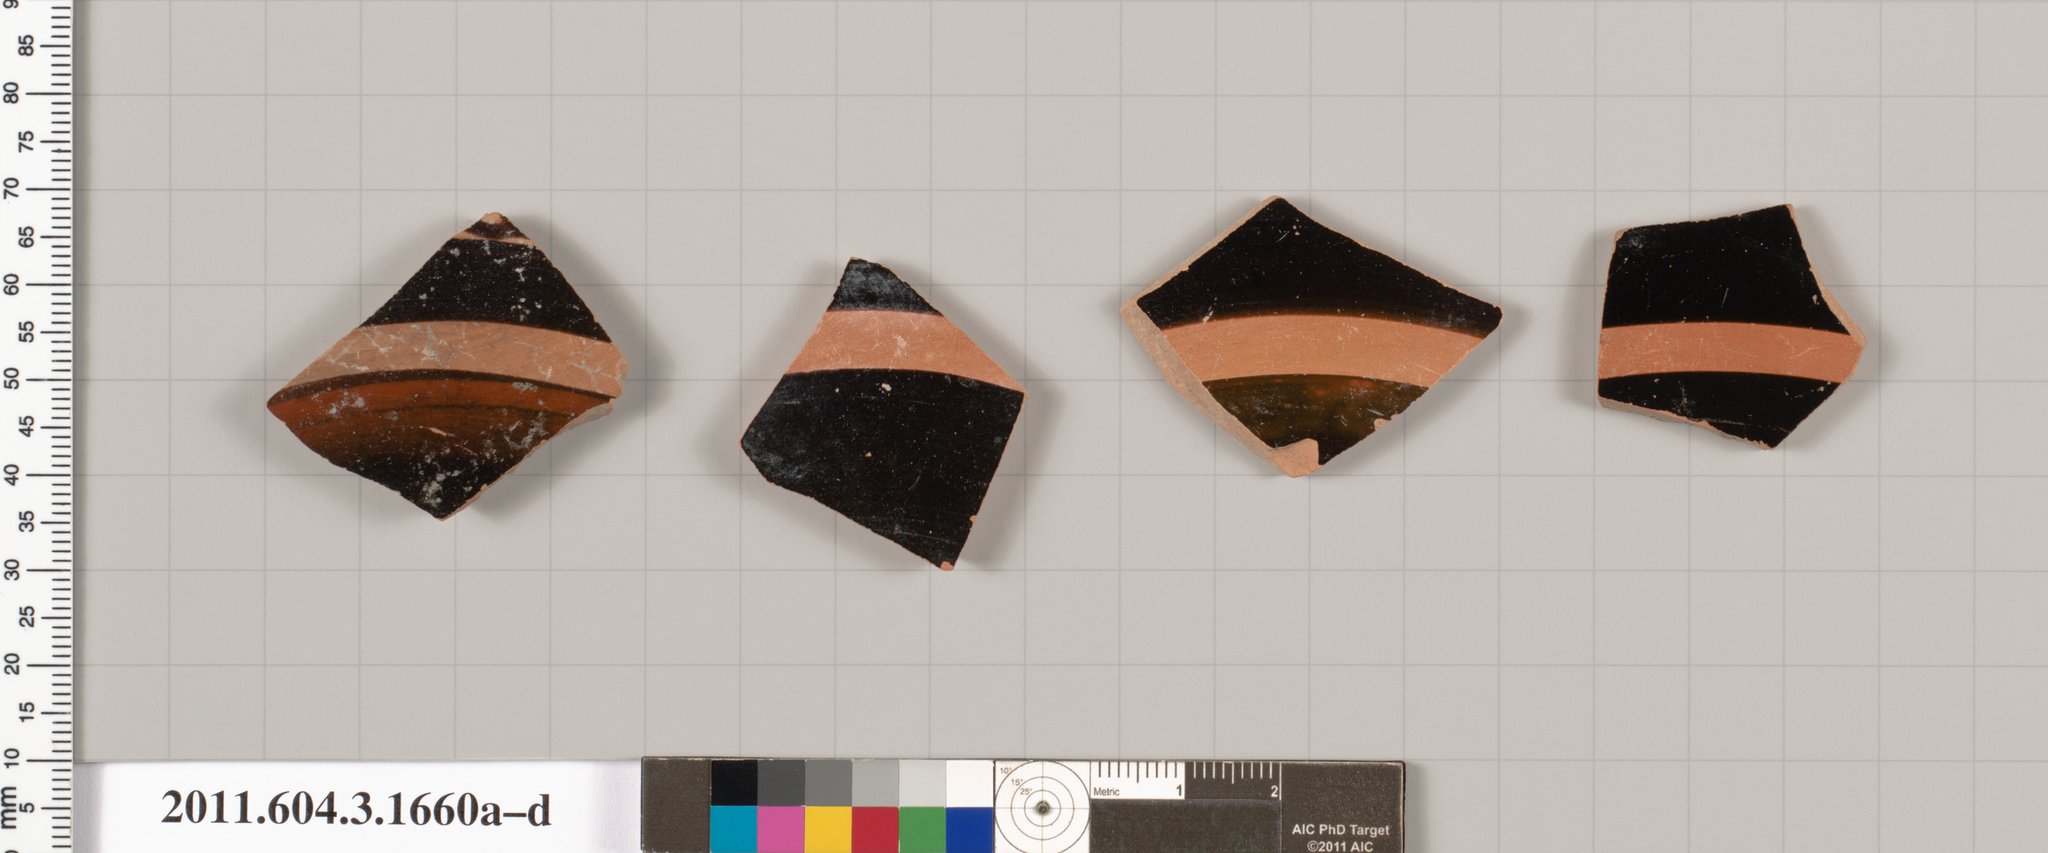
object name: kylix fragment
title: Terracotta fragments of kylikes: Band or lip cups (drinking cups)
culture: greek, attic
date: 550-526 BCE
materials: terracotta